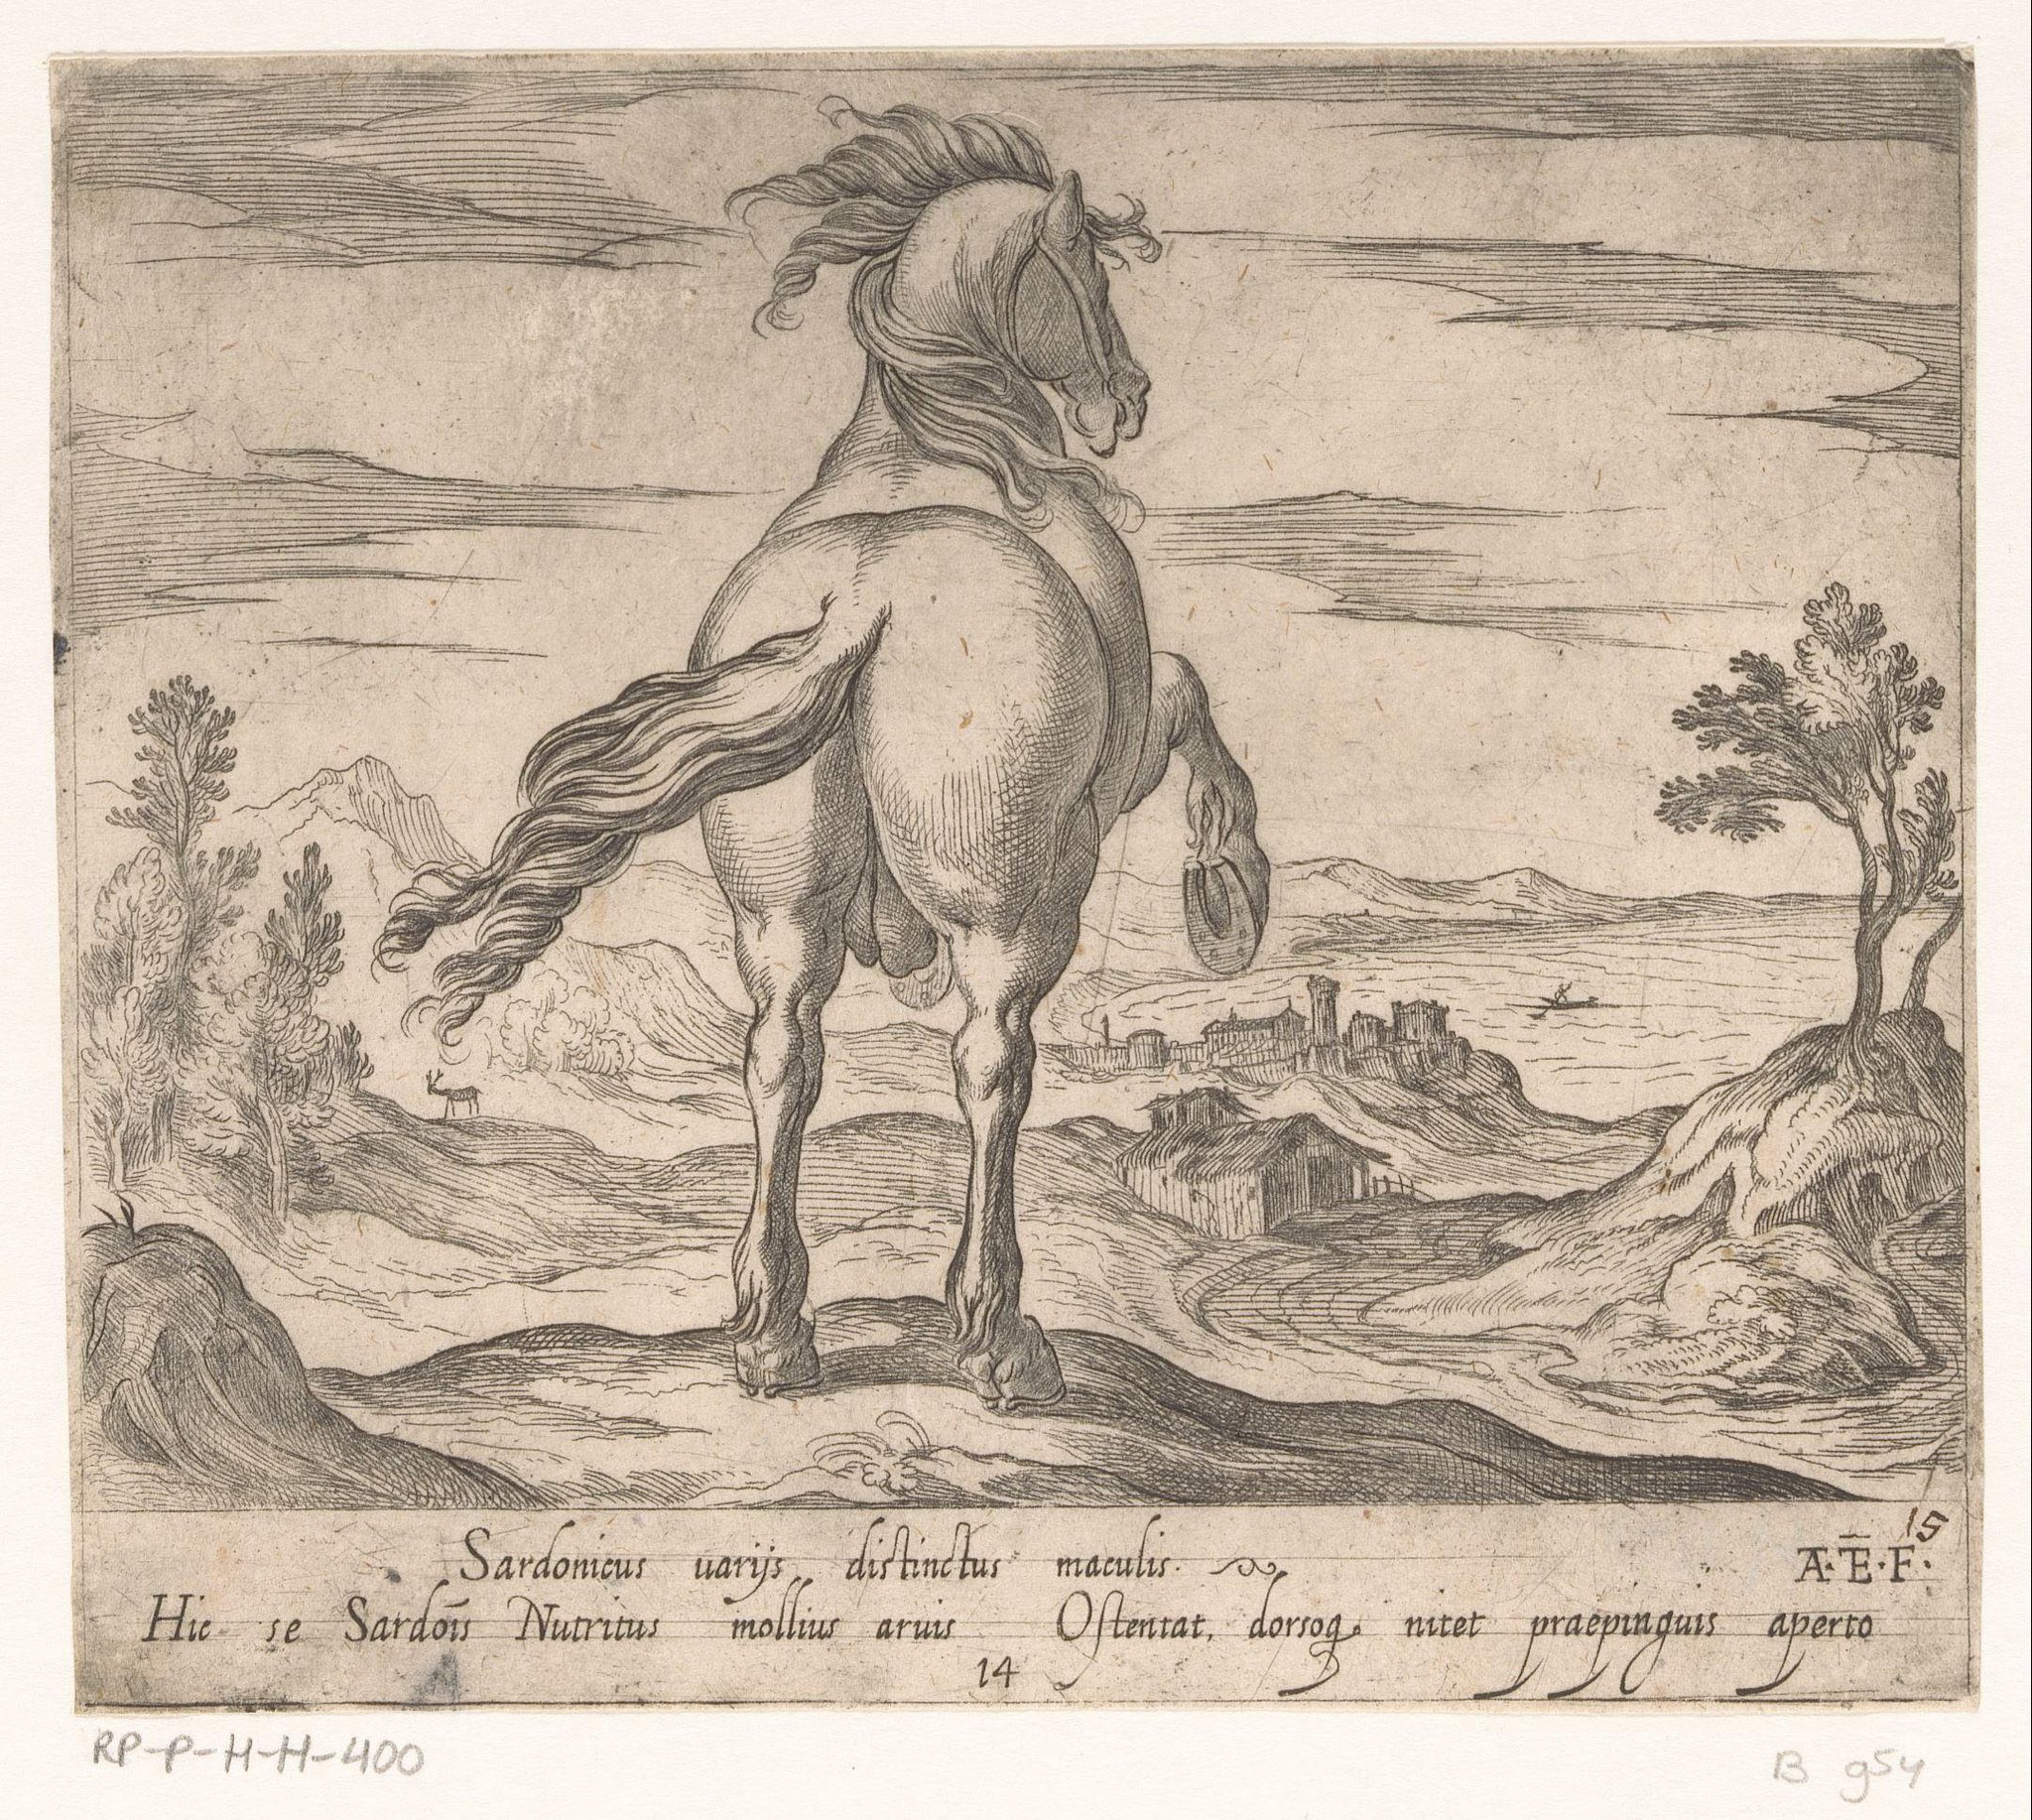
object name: print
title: His ducibus princeps celebraberis ore viroru illa homines beat haec sideribusq locat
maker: antonio tempesta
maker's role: draughtsman, painter, print maker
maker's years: 1555-1630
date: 1590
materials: paper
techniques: etching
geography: italy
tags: horse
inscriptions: collector's mark: ‘Hinloopen’, number: ‘15’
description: Deze prent maakt deel uit van een reeks van 28 prenten van paarden (+ titelprent en opdracht).